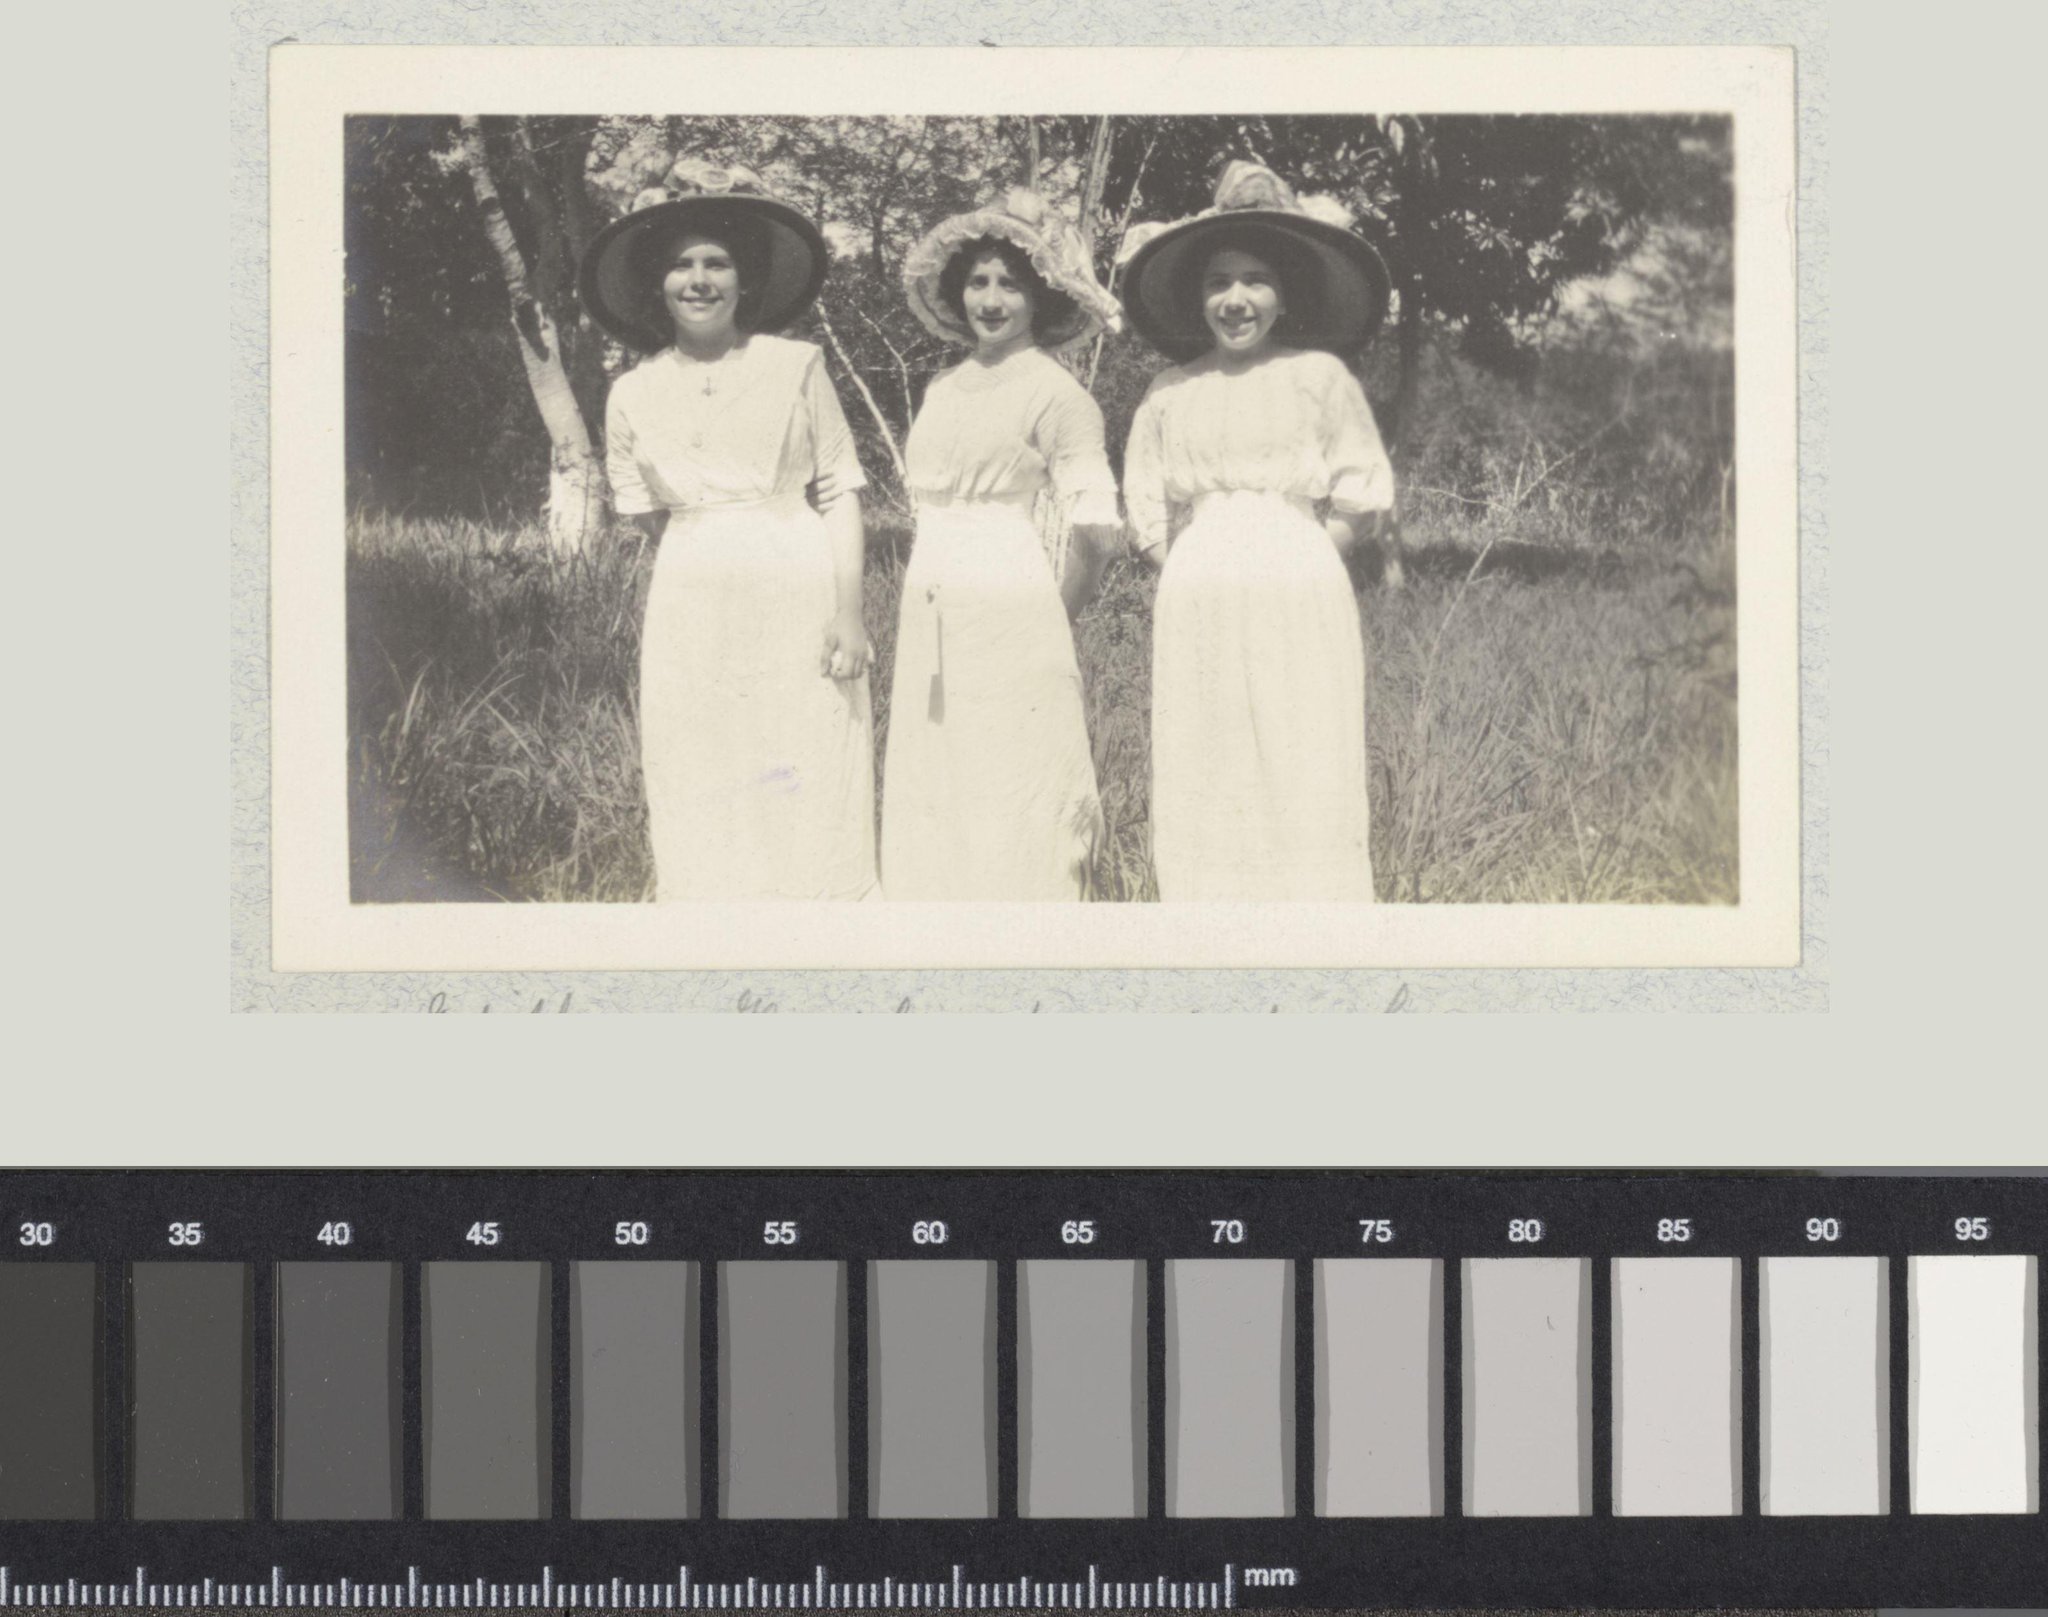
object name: photograph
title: Jongedames in Port-au-Prince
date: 1905-1912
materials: photographic support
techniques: photography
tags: port-au-prince, haïti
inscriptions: inscription: ‘Edith von Heydebrand und der Lasa / Fernande d'Aubignuy / Nini Coles / P. au P. Mei 1912’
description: Portret van drie jongedames die staand naast elkaar poseren, in Port-au-Prince op Haïti, mei 1912. Onderdeel van het fotoalbum van de familie Boom-Gonggrijp in Suriname en Curaçao.